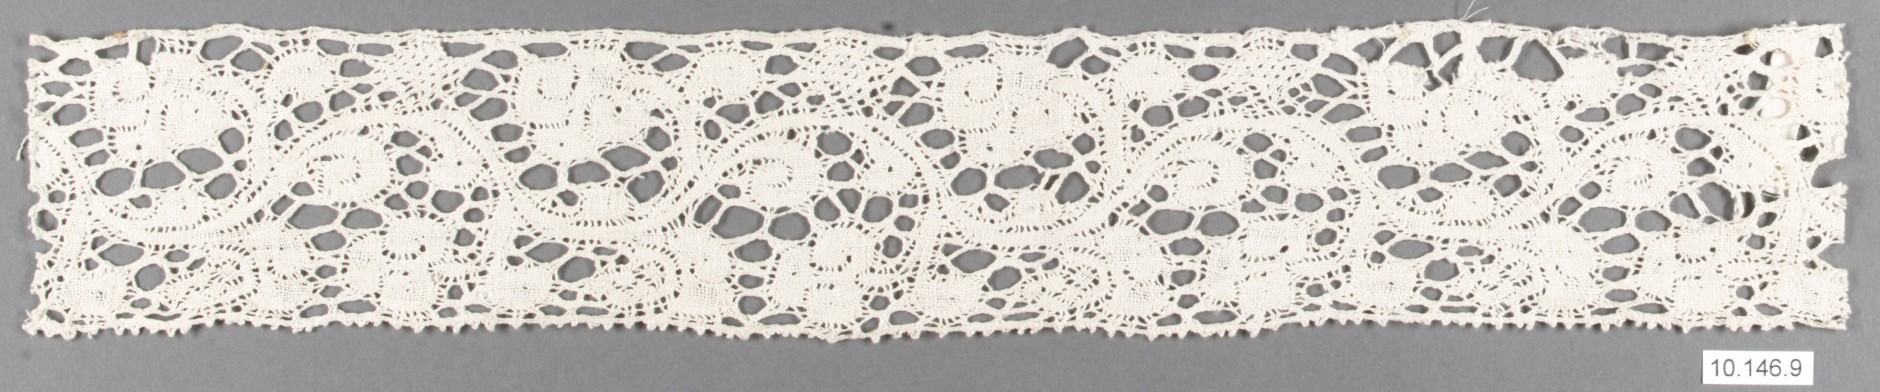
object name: bobbin lace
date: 1701-1800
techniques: lace